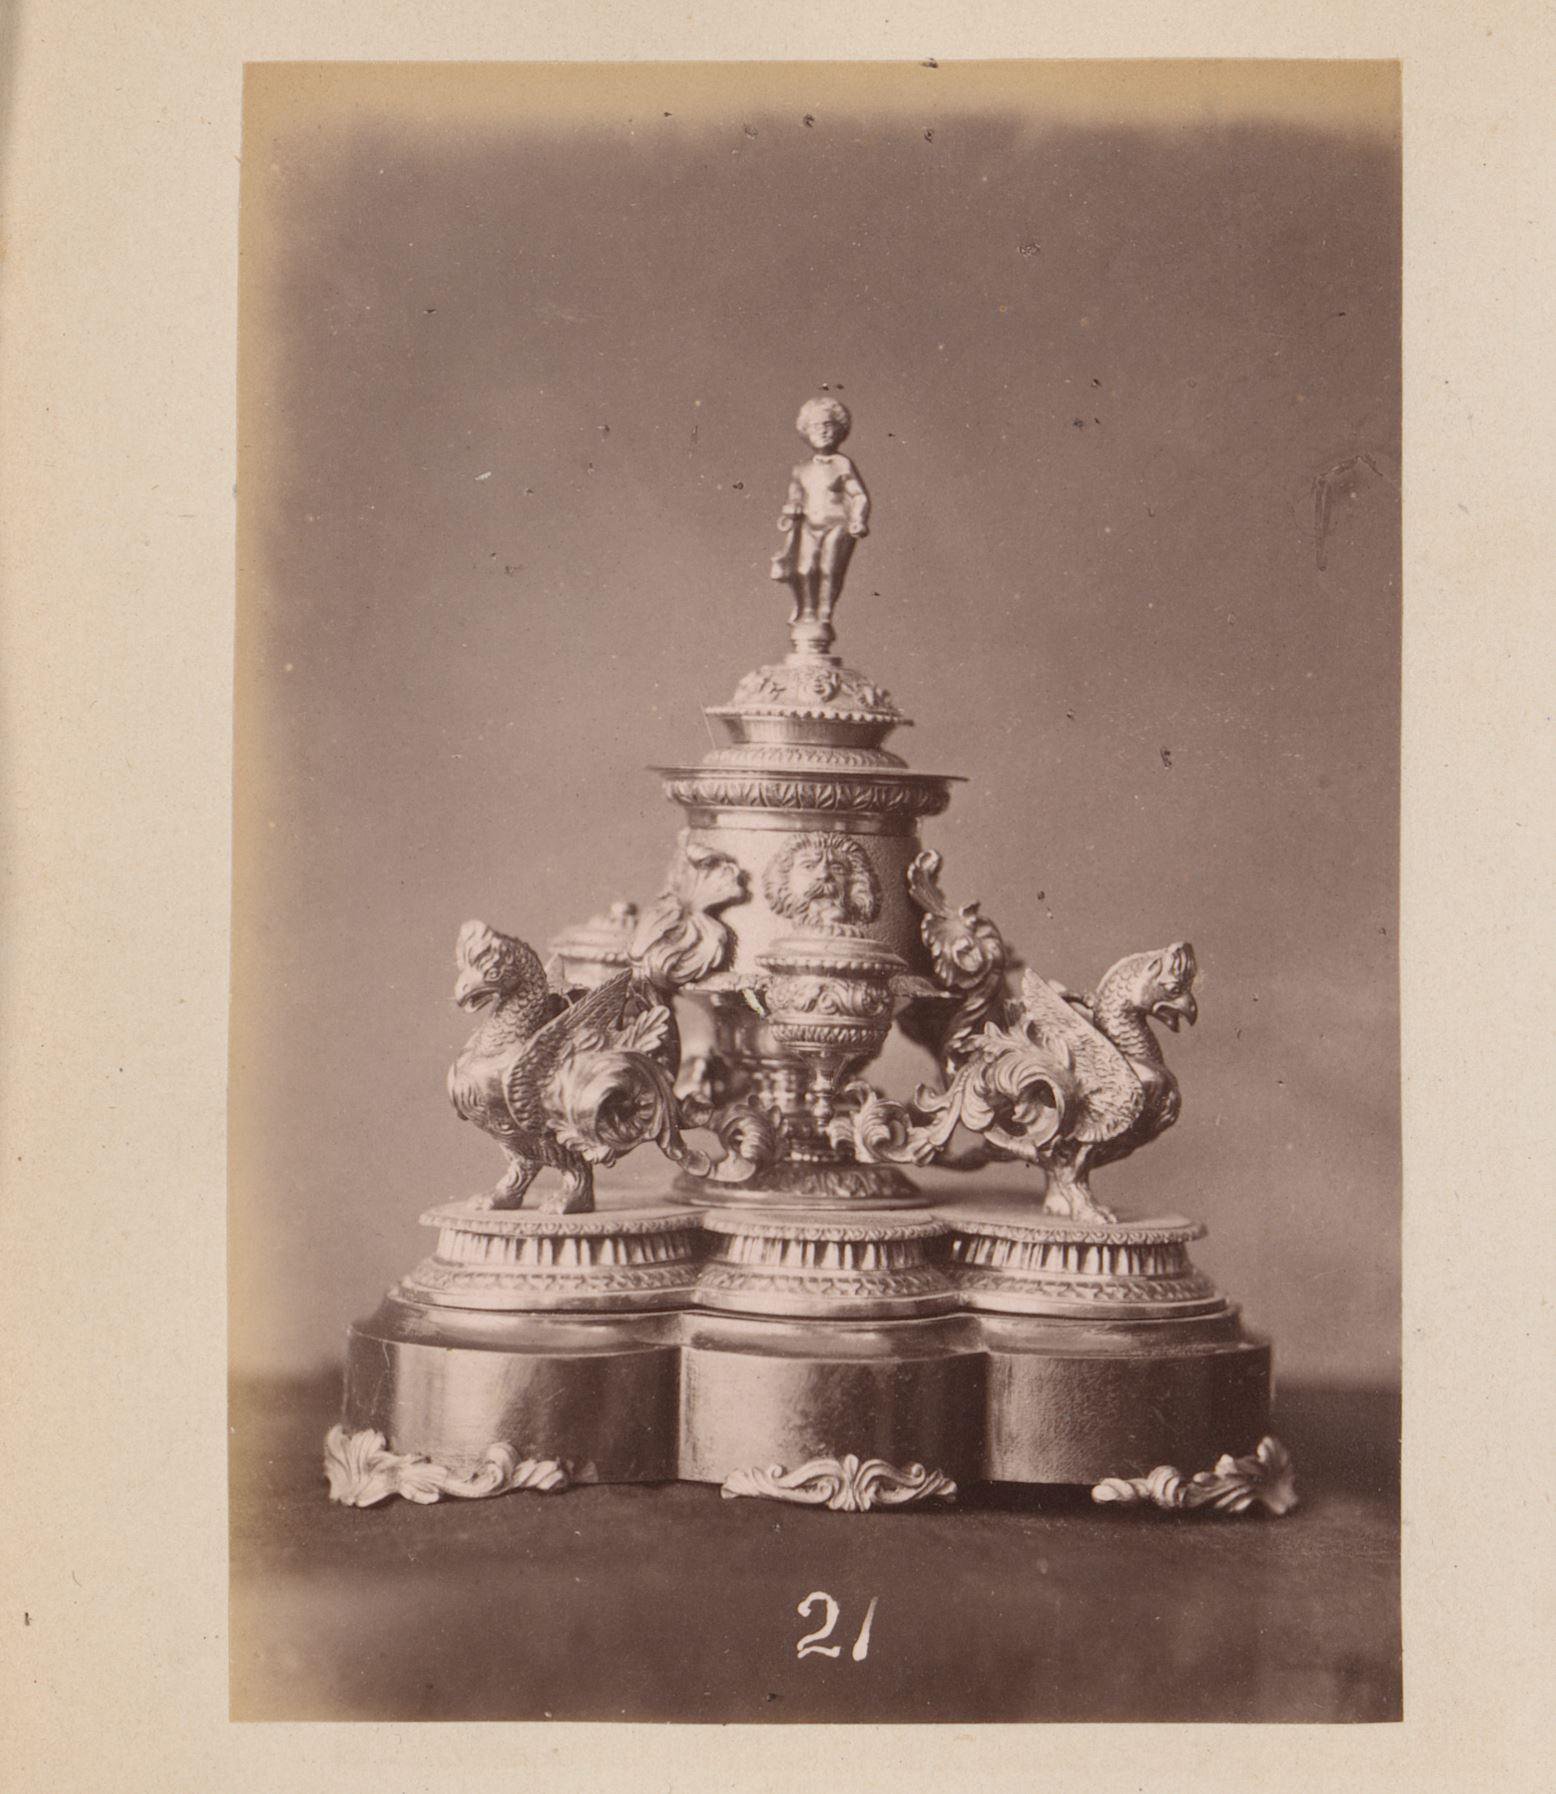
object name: photograph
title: Metalen tafelstuk met een kind en een griffioenen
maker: Anonymous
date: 1860-1885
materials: photographic support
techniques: albumen print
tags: griffin (lion/eagle); 'griffo' (ripa), child